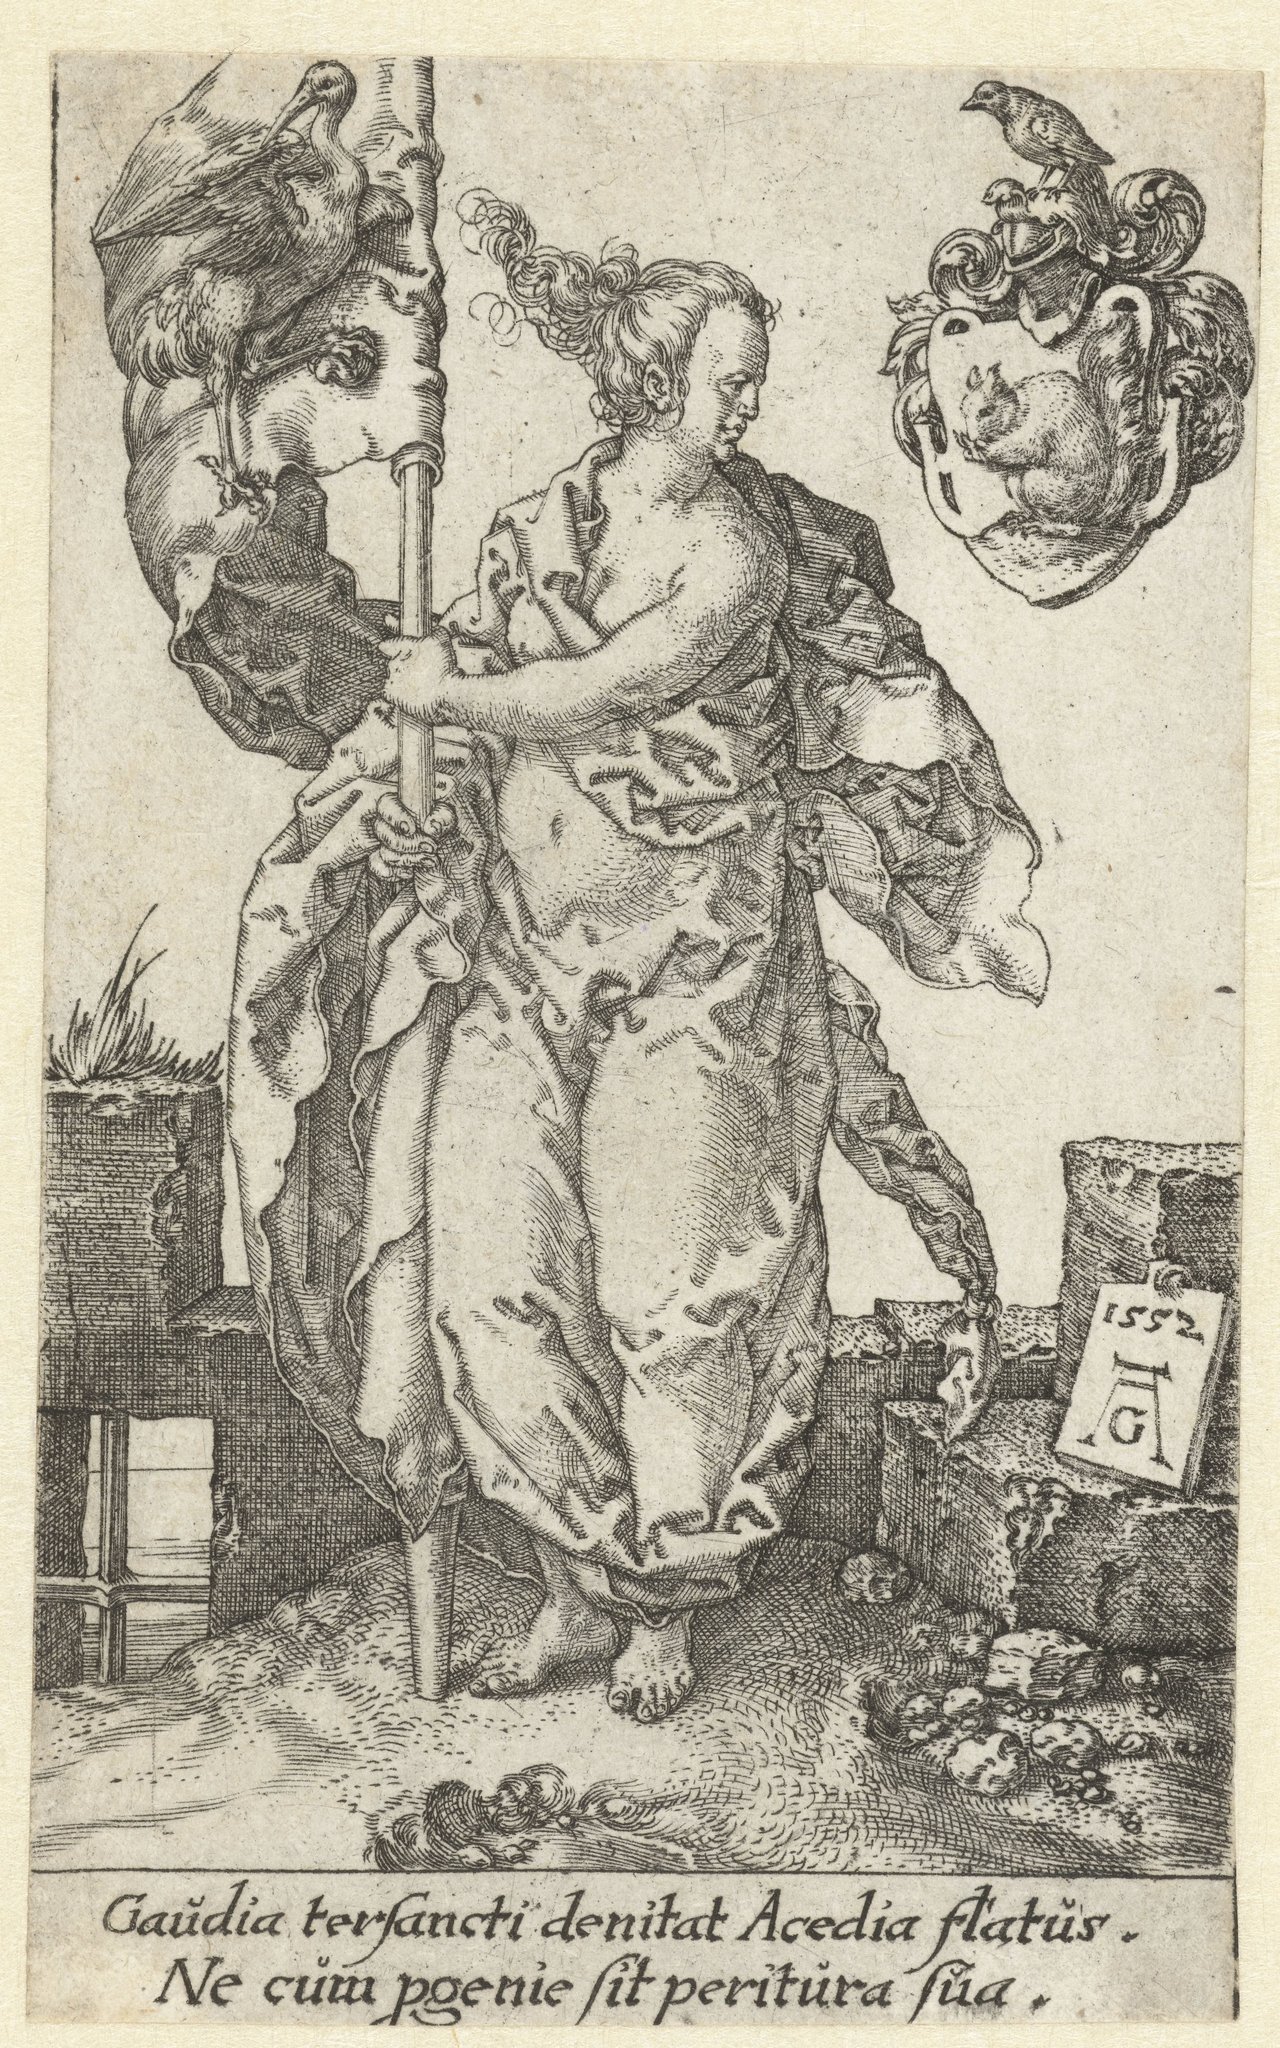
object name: print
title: Zeven Deugden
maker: heinrich aldegrever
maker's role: draughtsman, print maker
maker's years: 1502-1561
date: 1552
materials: paper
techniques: engraving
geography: germany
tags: carefulness, diligence; 'diligenza' (ripa) (+ abstract concept represented by female figure)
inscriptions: collector's mark: Lugt 11, collector's mark: ‘Hinloopen’ Lugt 11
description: Personificatie van zorgvuldigheid. Vrouw, staand met een vaandel waarop een kraanvogel met een steen in de poot is afgebeeld. Rechtsboven een wapenschild met een eekhoorn, daarboven een vogel. Onder de voorstelling een tweeregelige tekst in het Latijn. Zevende prent uit een serie van zeven.